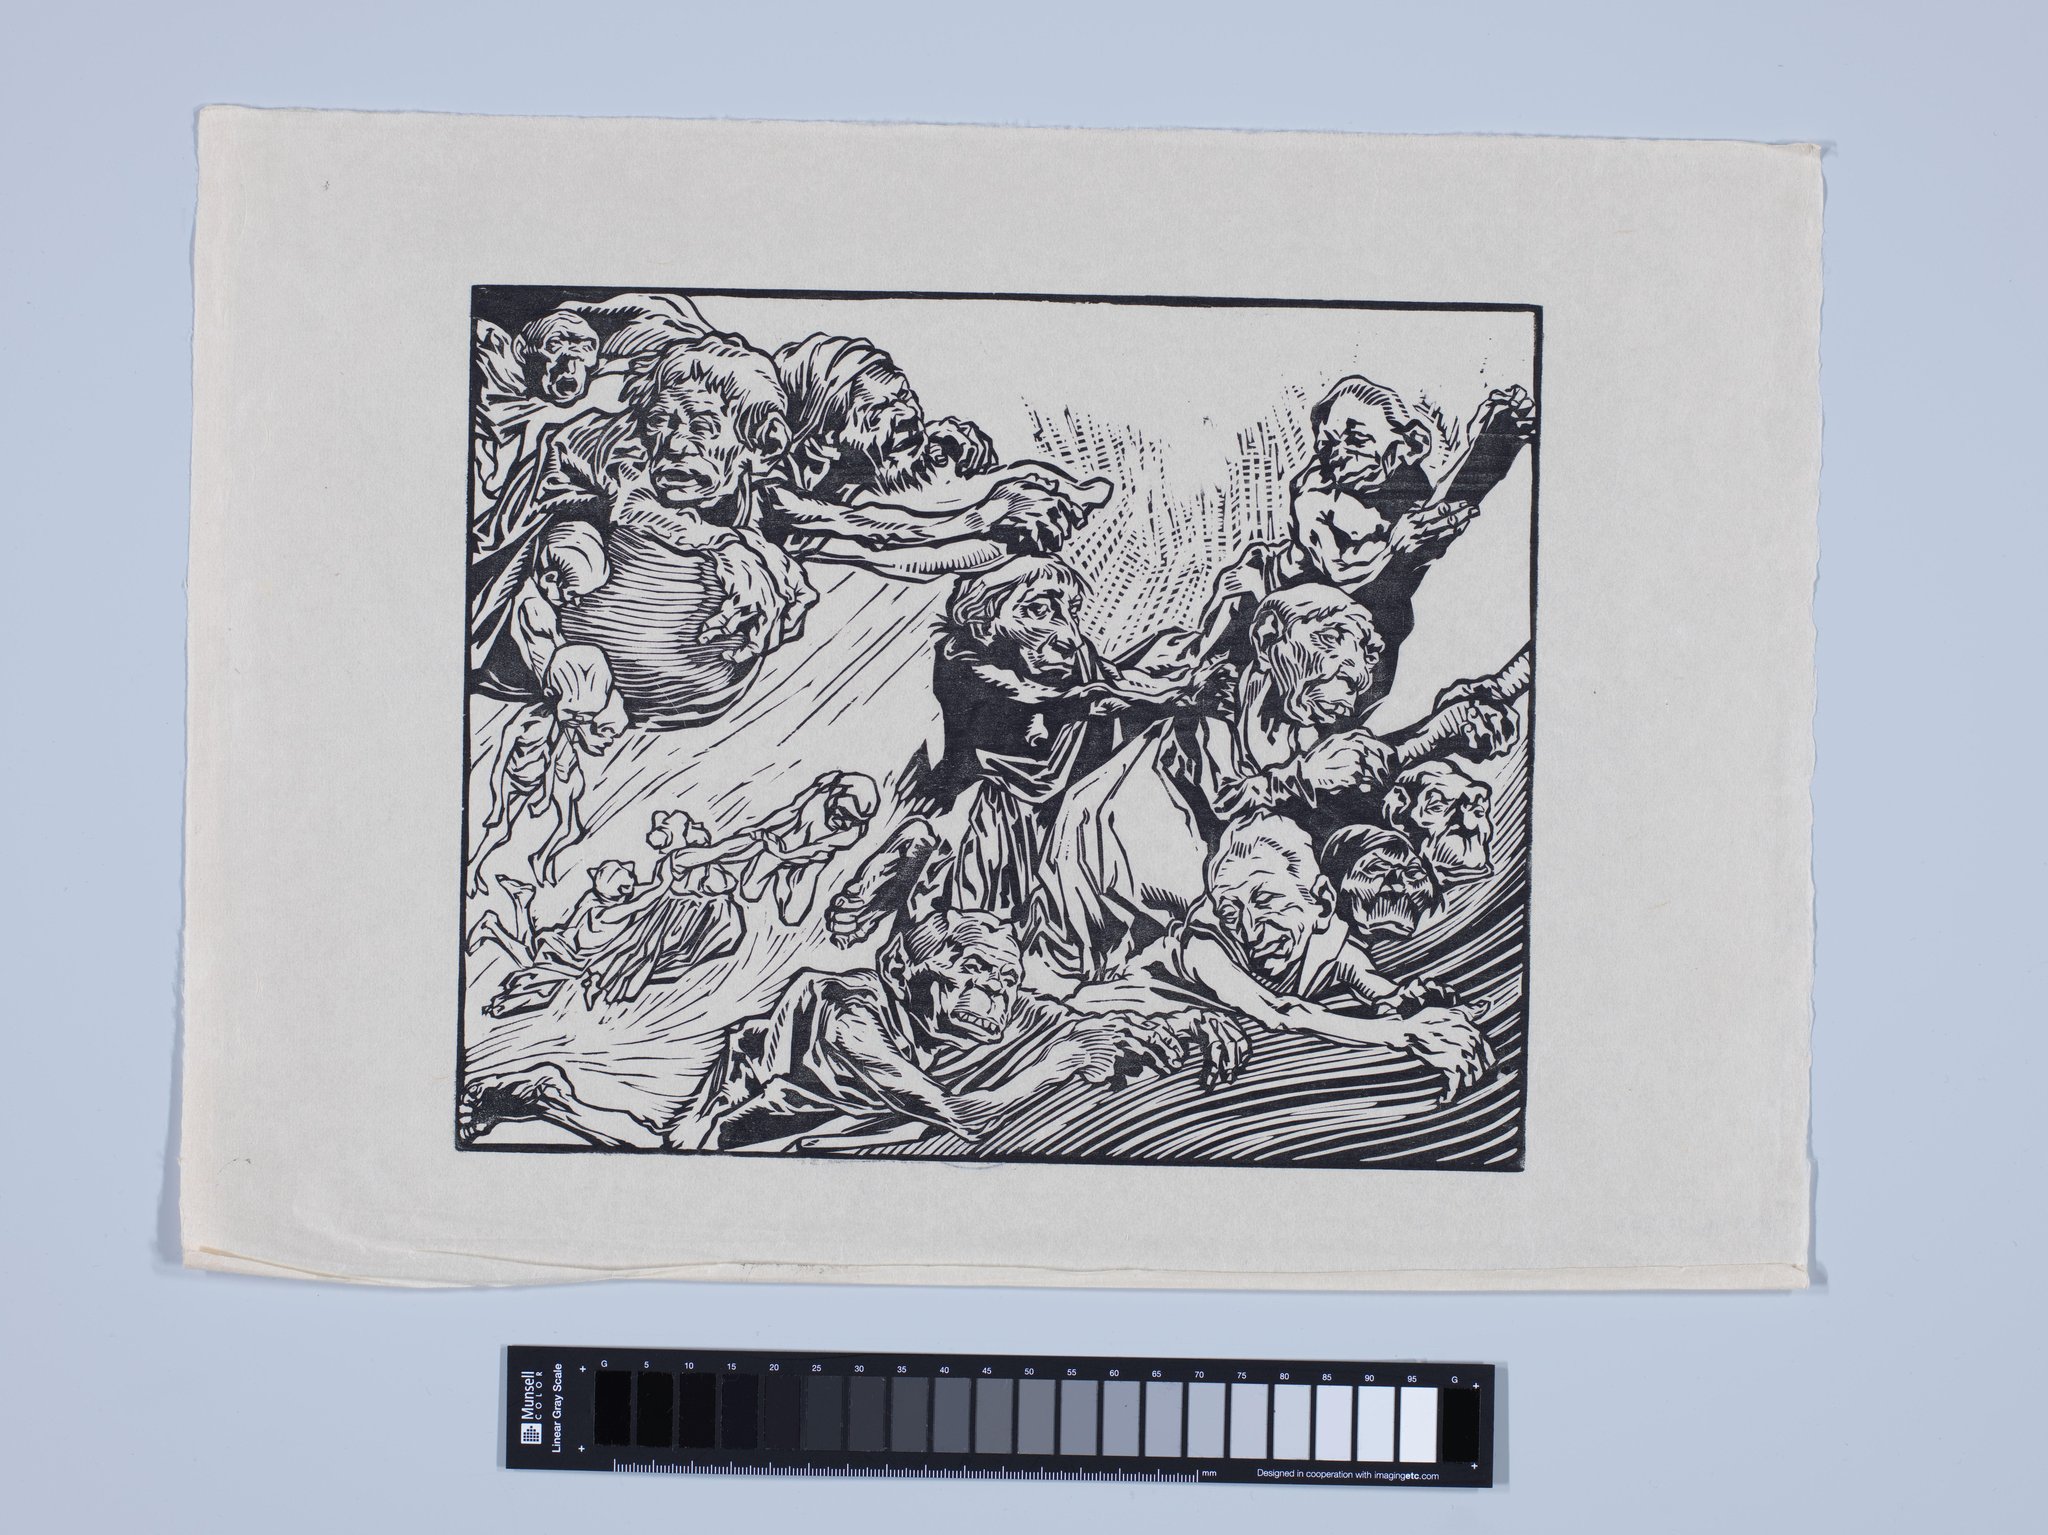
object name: print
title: Zwevende fantasiewezens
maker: johannes josephus aarts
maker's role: draughtsman, print maker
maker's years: 1871-1934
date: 1881-1934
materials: paper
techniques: woodcut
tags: movement in the air, surrealia, surrealistic representations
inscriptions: collector's mark: Lugt 2228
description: Verschillende groepen fantasiewezens bewegen zich voort door de lucht.